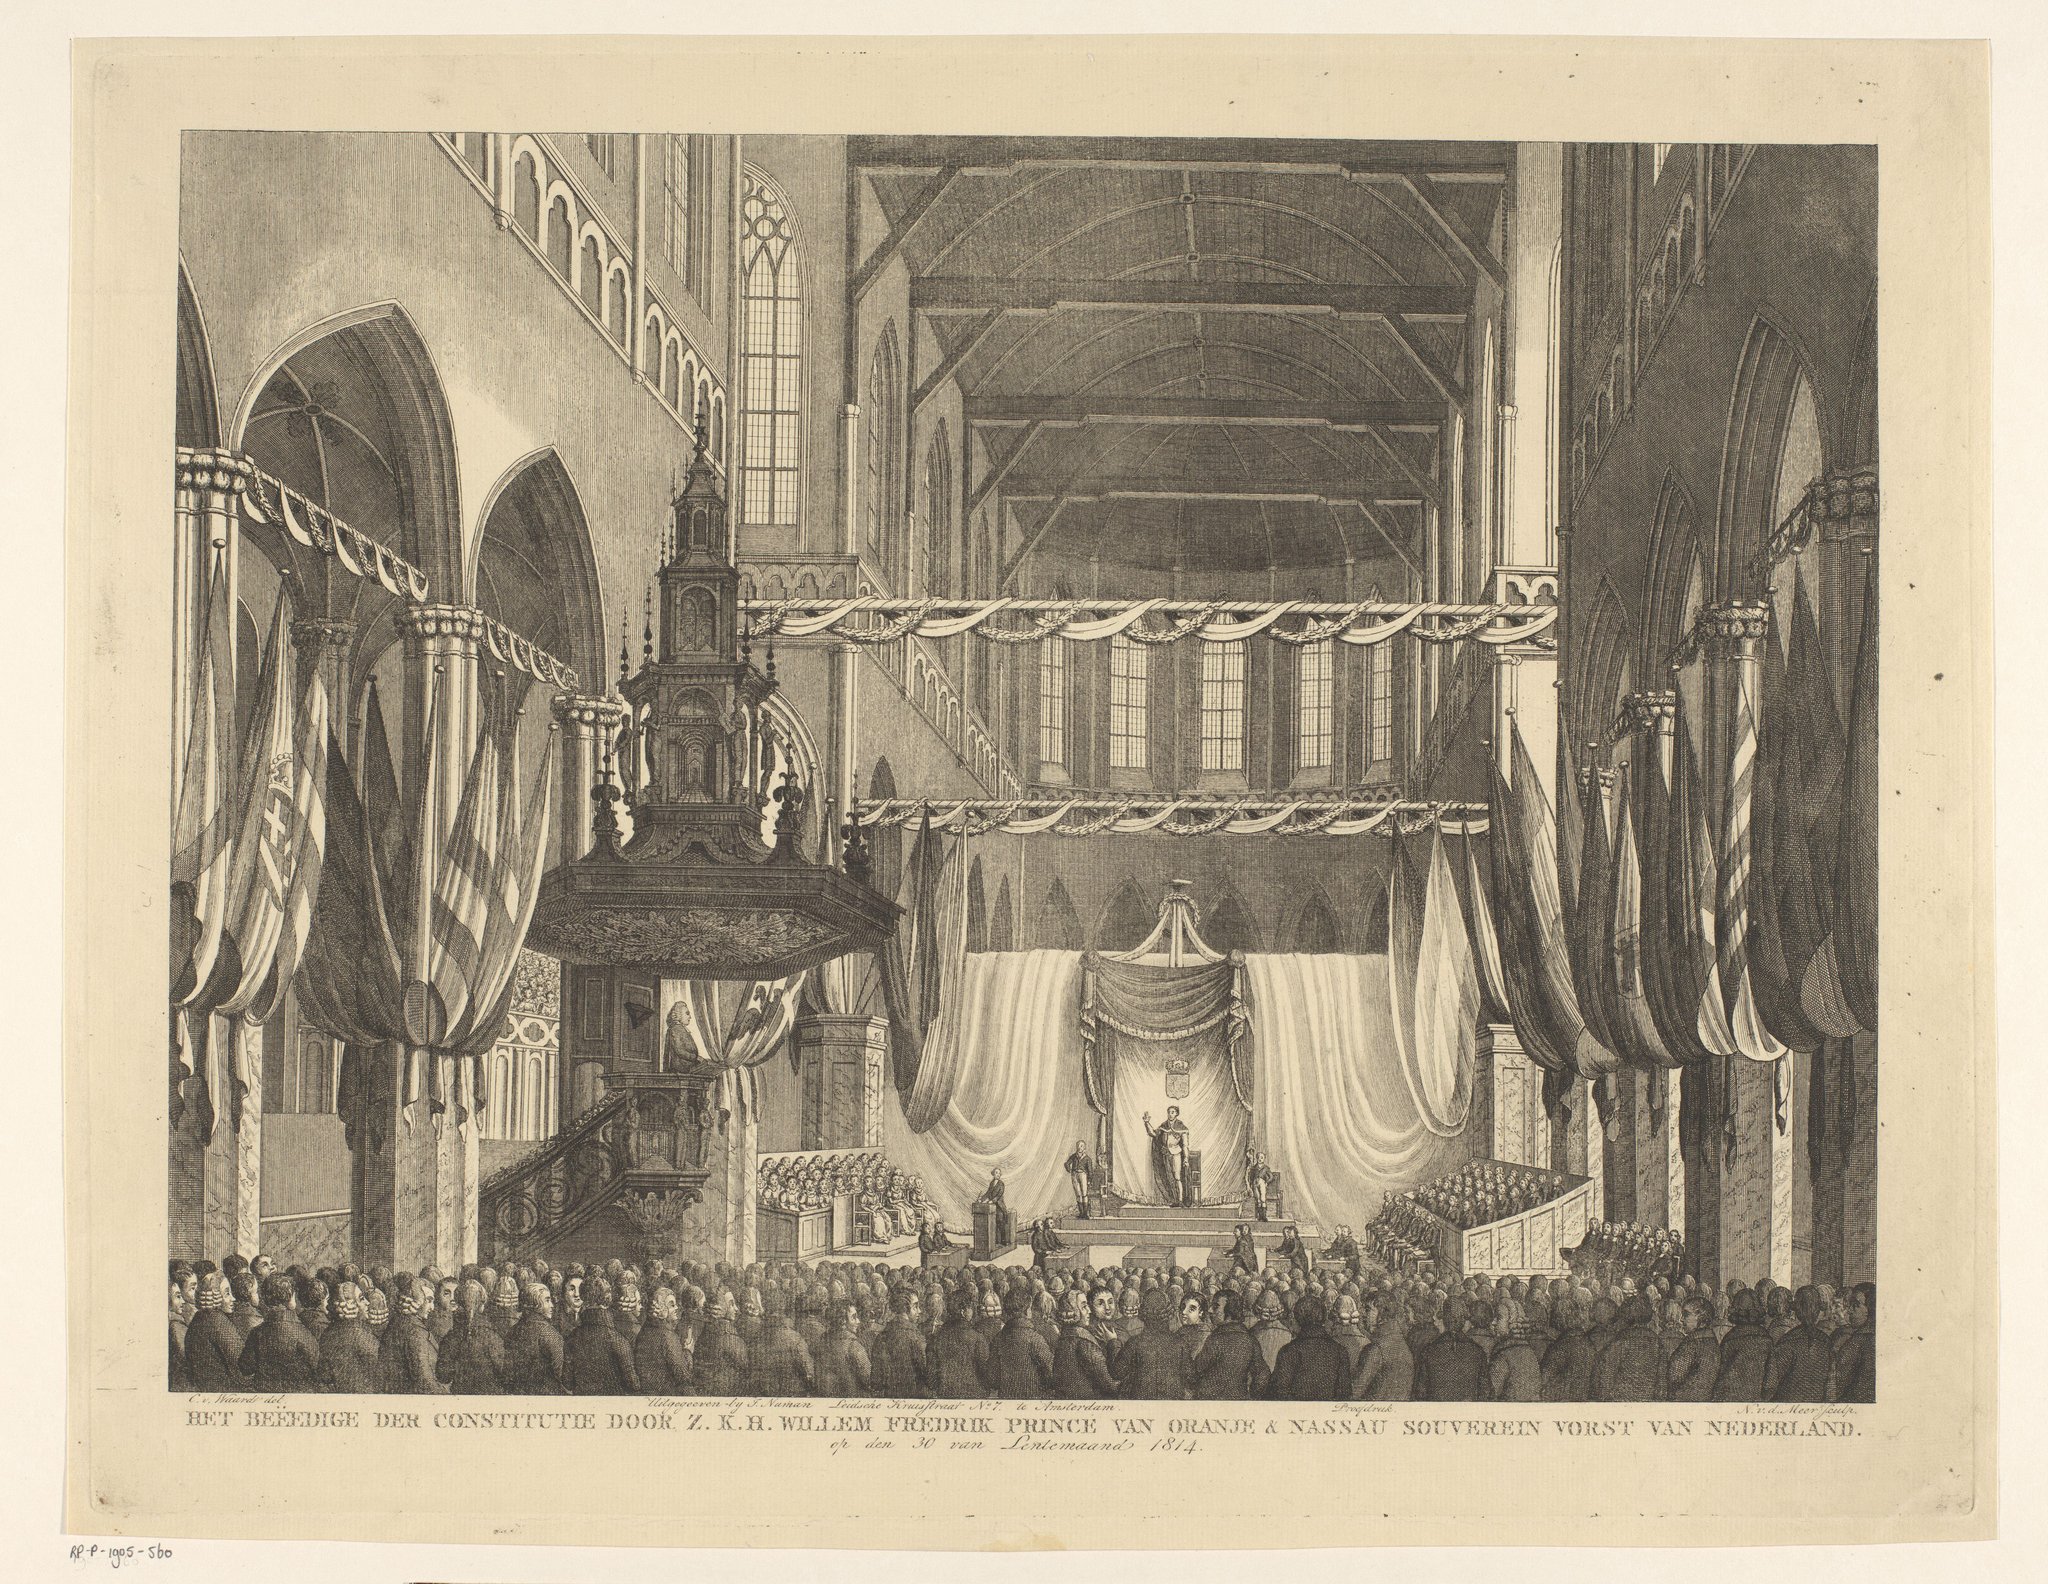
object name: print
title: Het beëedige der constitutie door Z.K.H. Willem Frederik Prince van Oranje (...)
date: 1814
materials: paper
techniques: etching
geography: amsterdam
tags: the hague, berlin, william i of the netherlands, interior of church, ruler, sovereign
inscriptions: collector's mark: Lugt 2228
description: De inhuldiging van Willem I Frederik als soeverein vorst van Nederland op 30 maart 1814 in de Nieuwe Kerk te Amsterdam. Staand onder een baldakijn legt Willem Frederik de eed af. Links de dominee op de preekstoel.